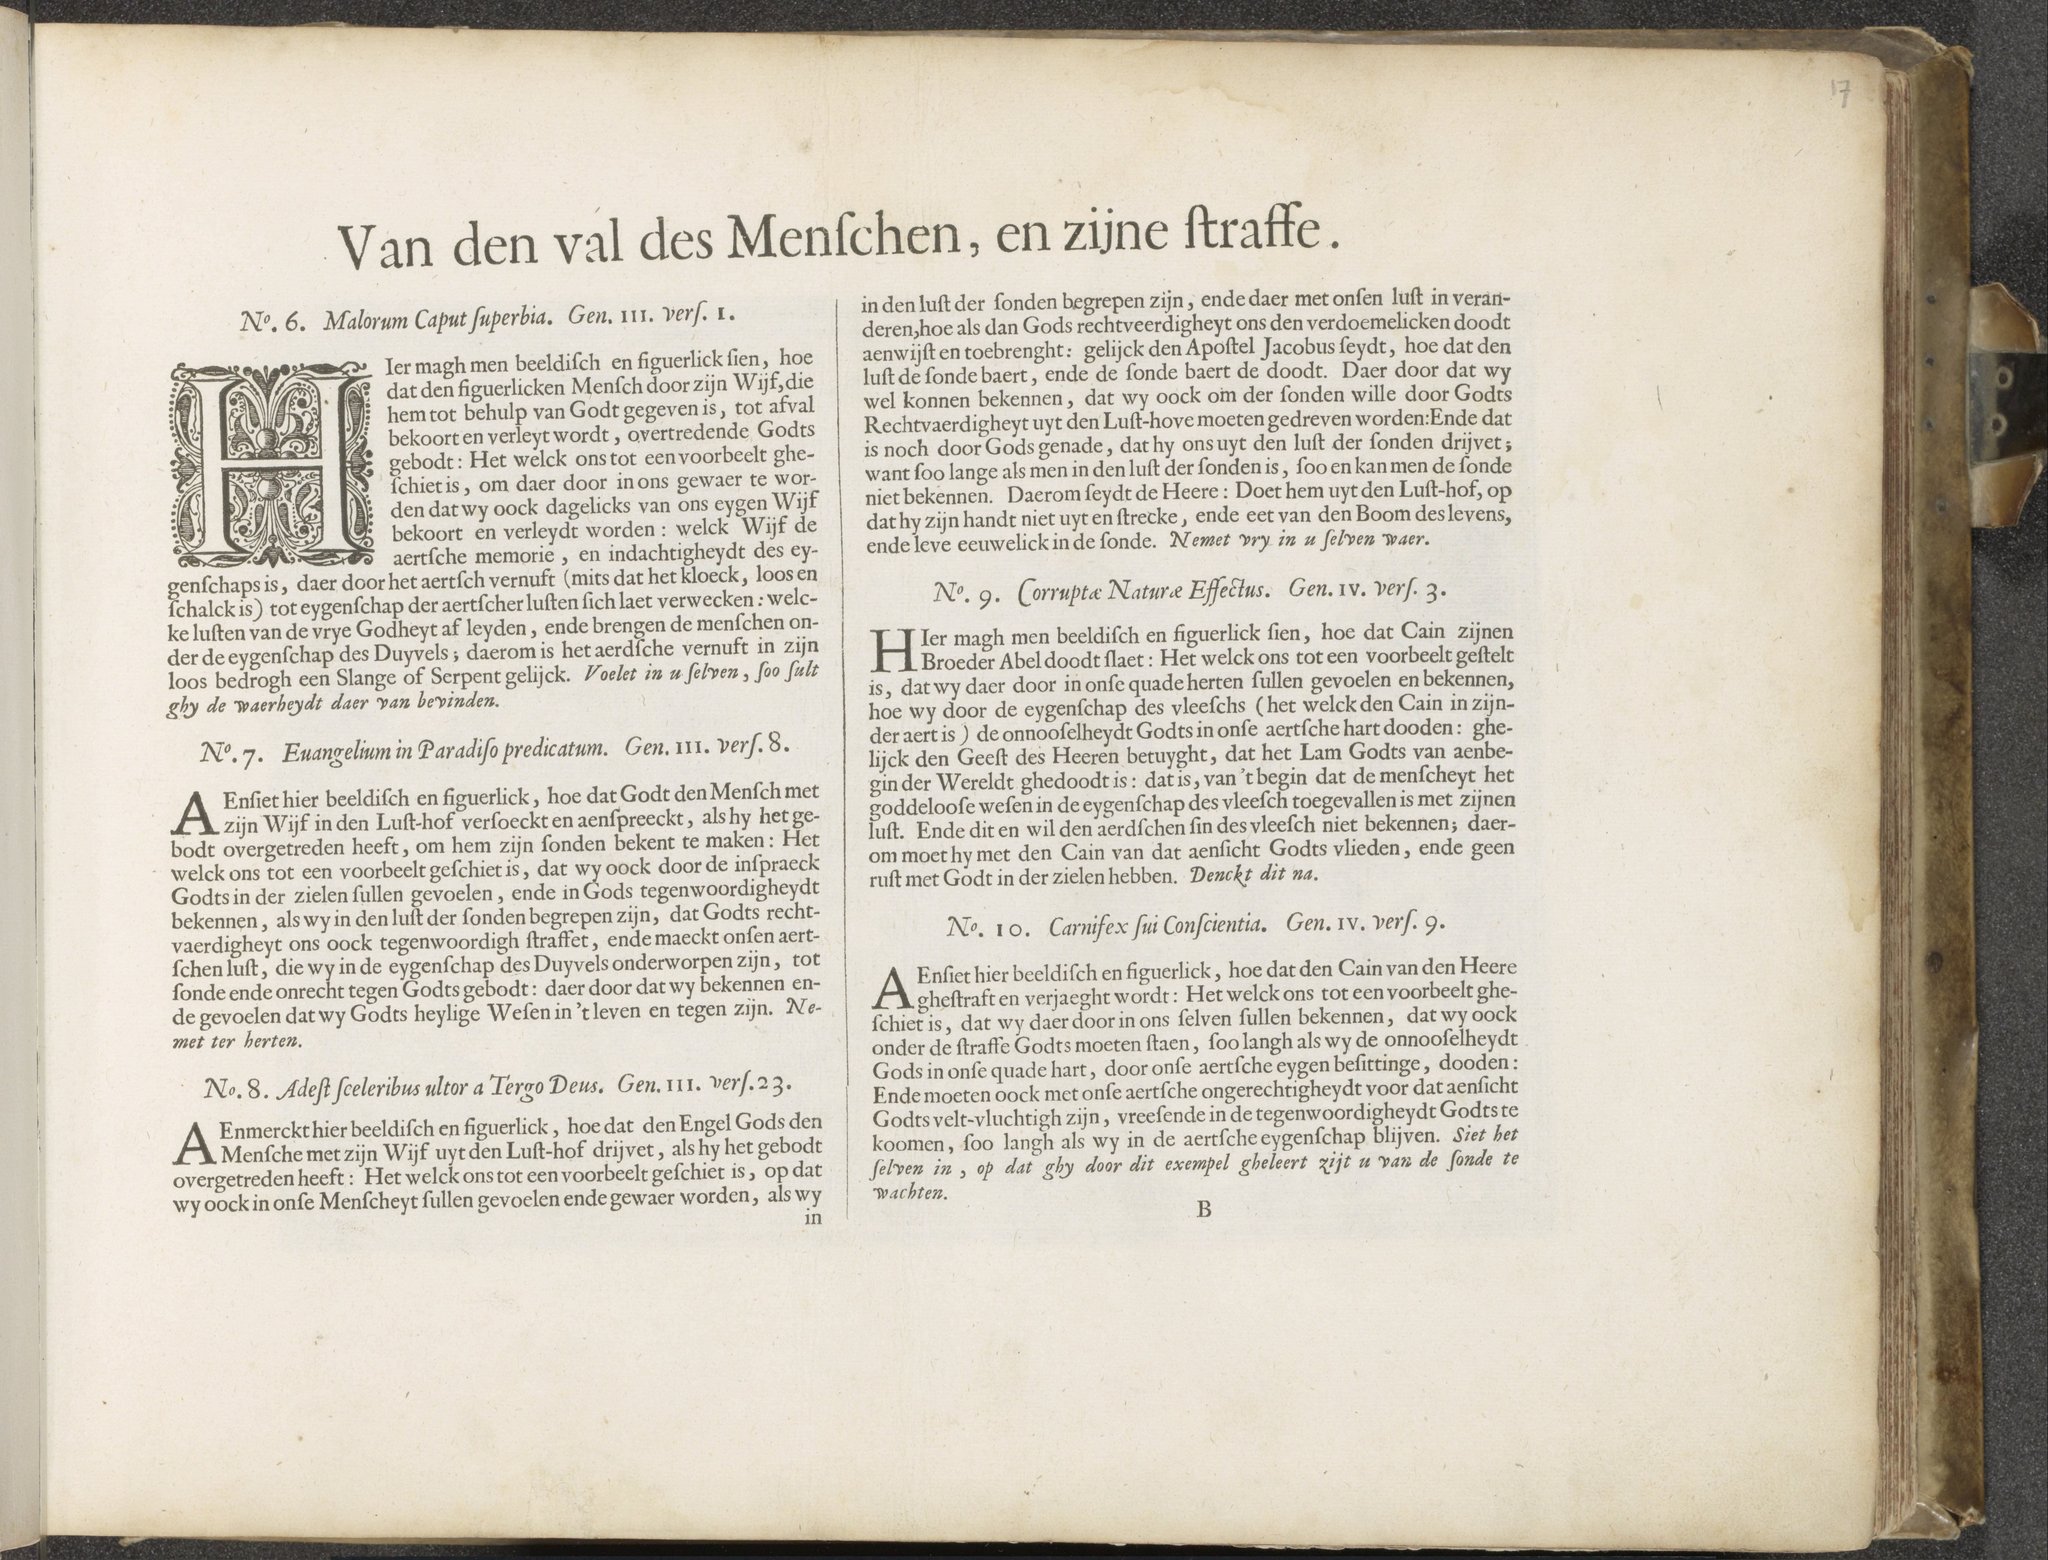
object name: text sheet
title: Vijf toelichtingen bij voorstellingen over de val van de mens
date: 1653-1654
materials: paper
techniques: letterpress printing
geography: amsterdam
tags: initial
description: Vijf toelichtingen bij voorstellingen over de val van de mens en zijn straf, genummerd zes tot en met tien. De tekst vangt aan met een gedecoreerde initiaal H. Het blad maakt deel uit van een album.